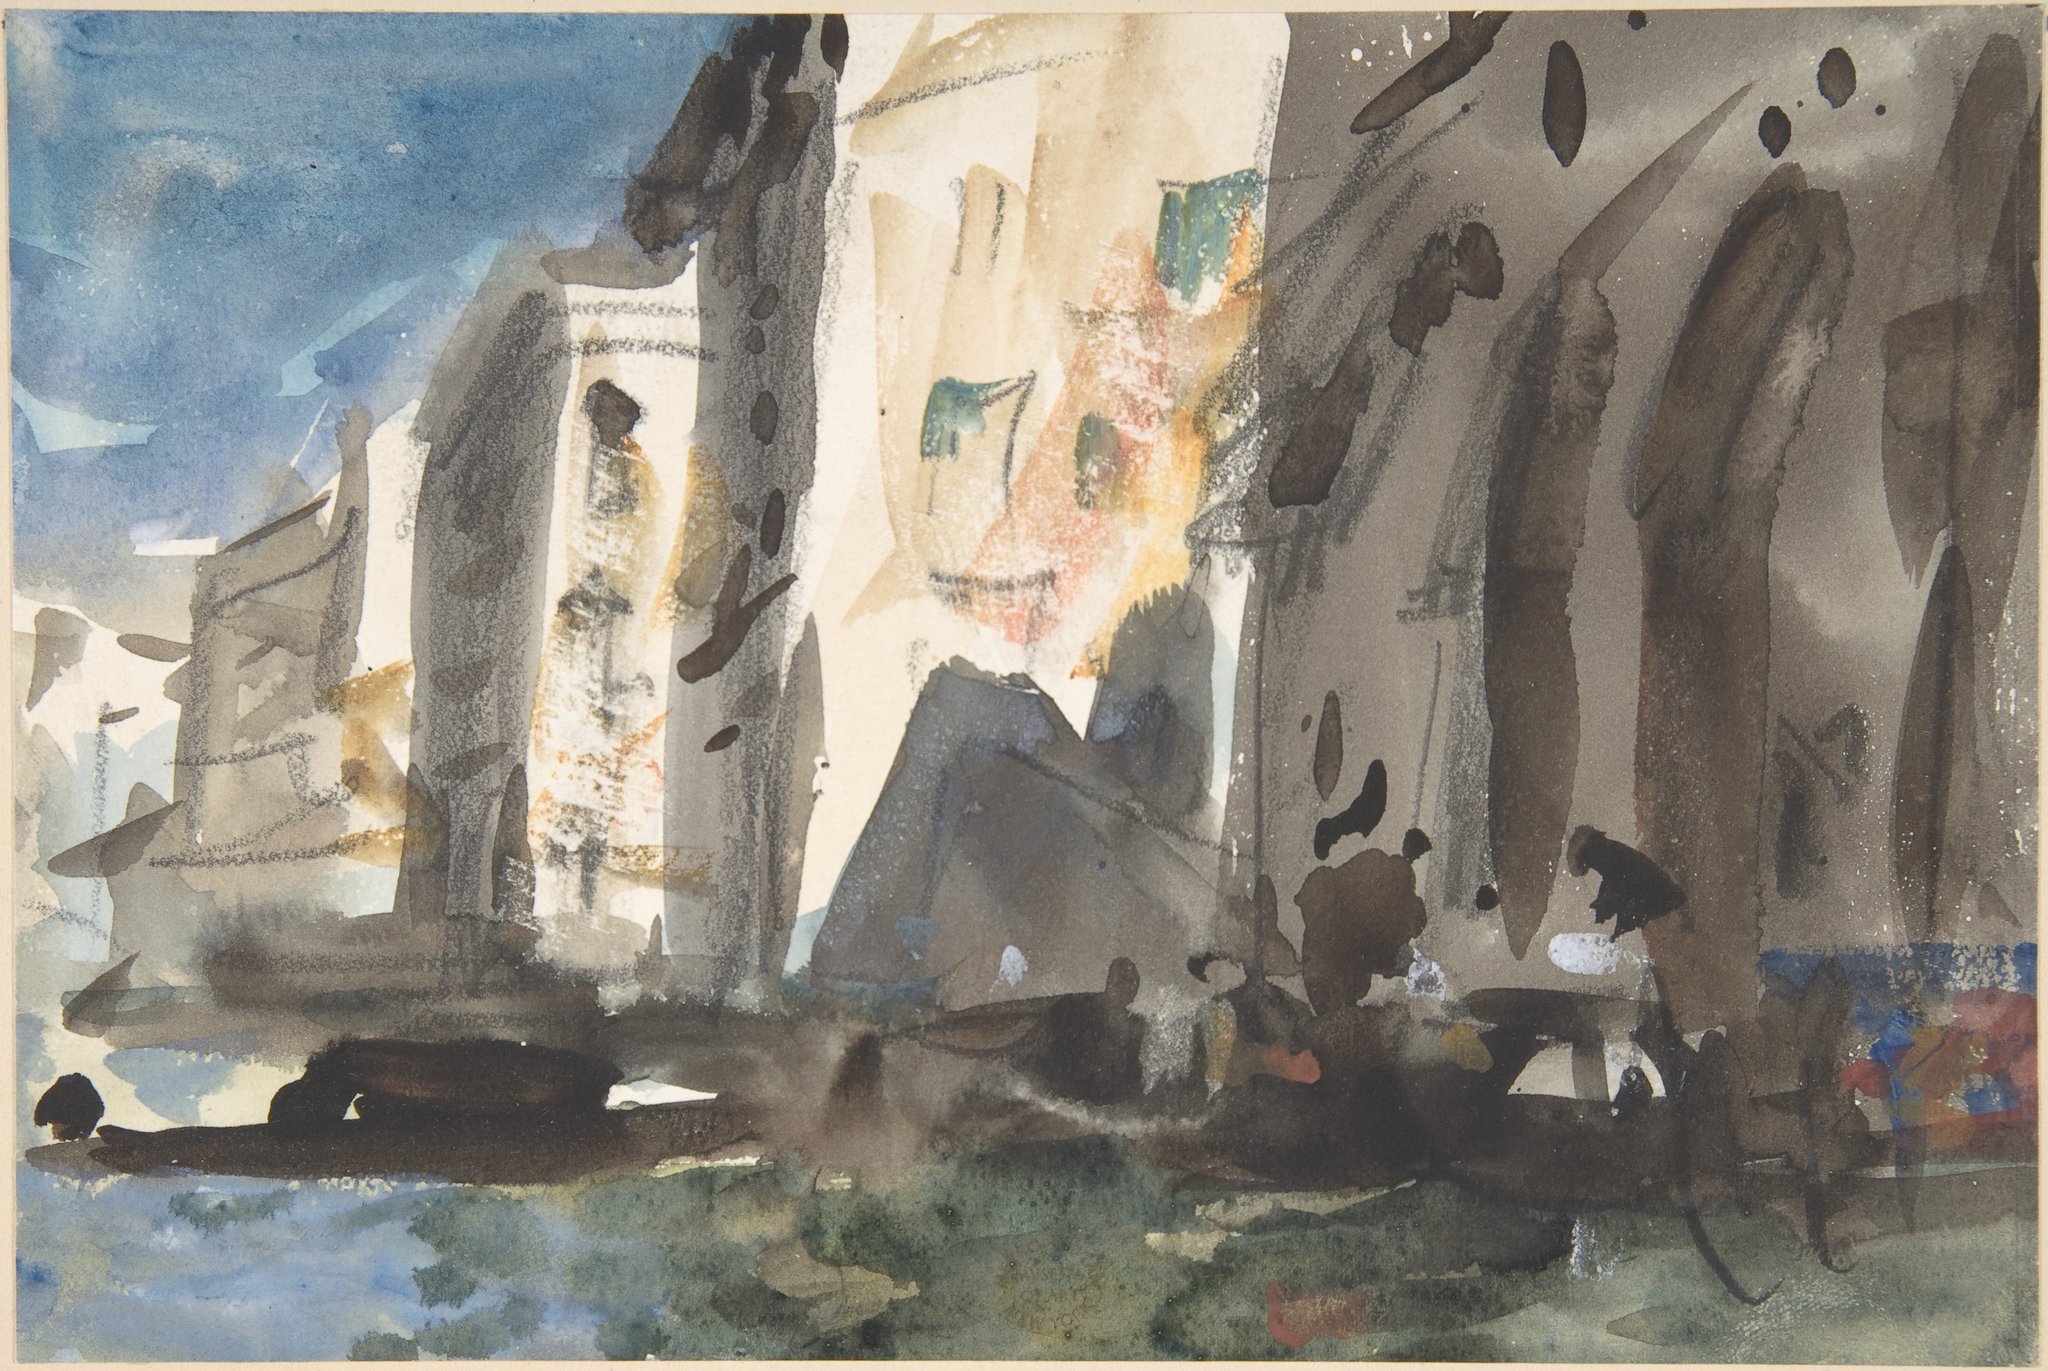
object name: drawing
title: On the Grand Canal, Venice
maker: hercules brabazon brabazon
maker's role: artist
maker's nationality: british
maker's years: 1821-1906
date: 1801-1900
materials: gouache, watercolor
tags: buildings,bridges,canals,venice